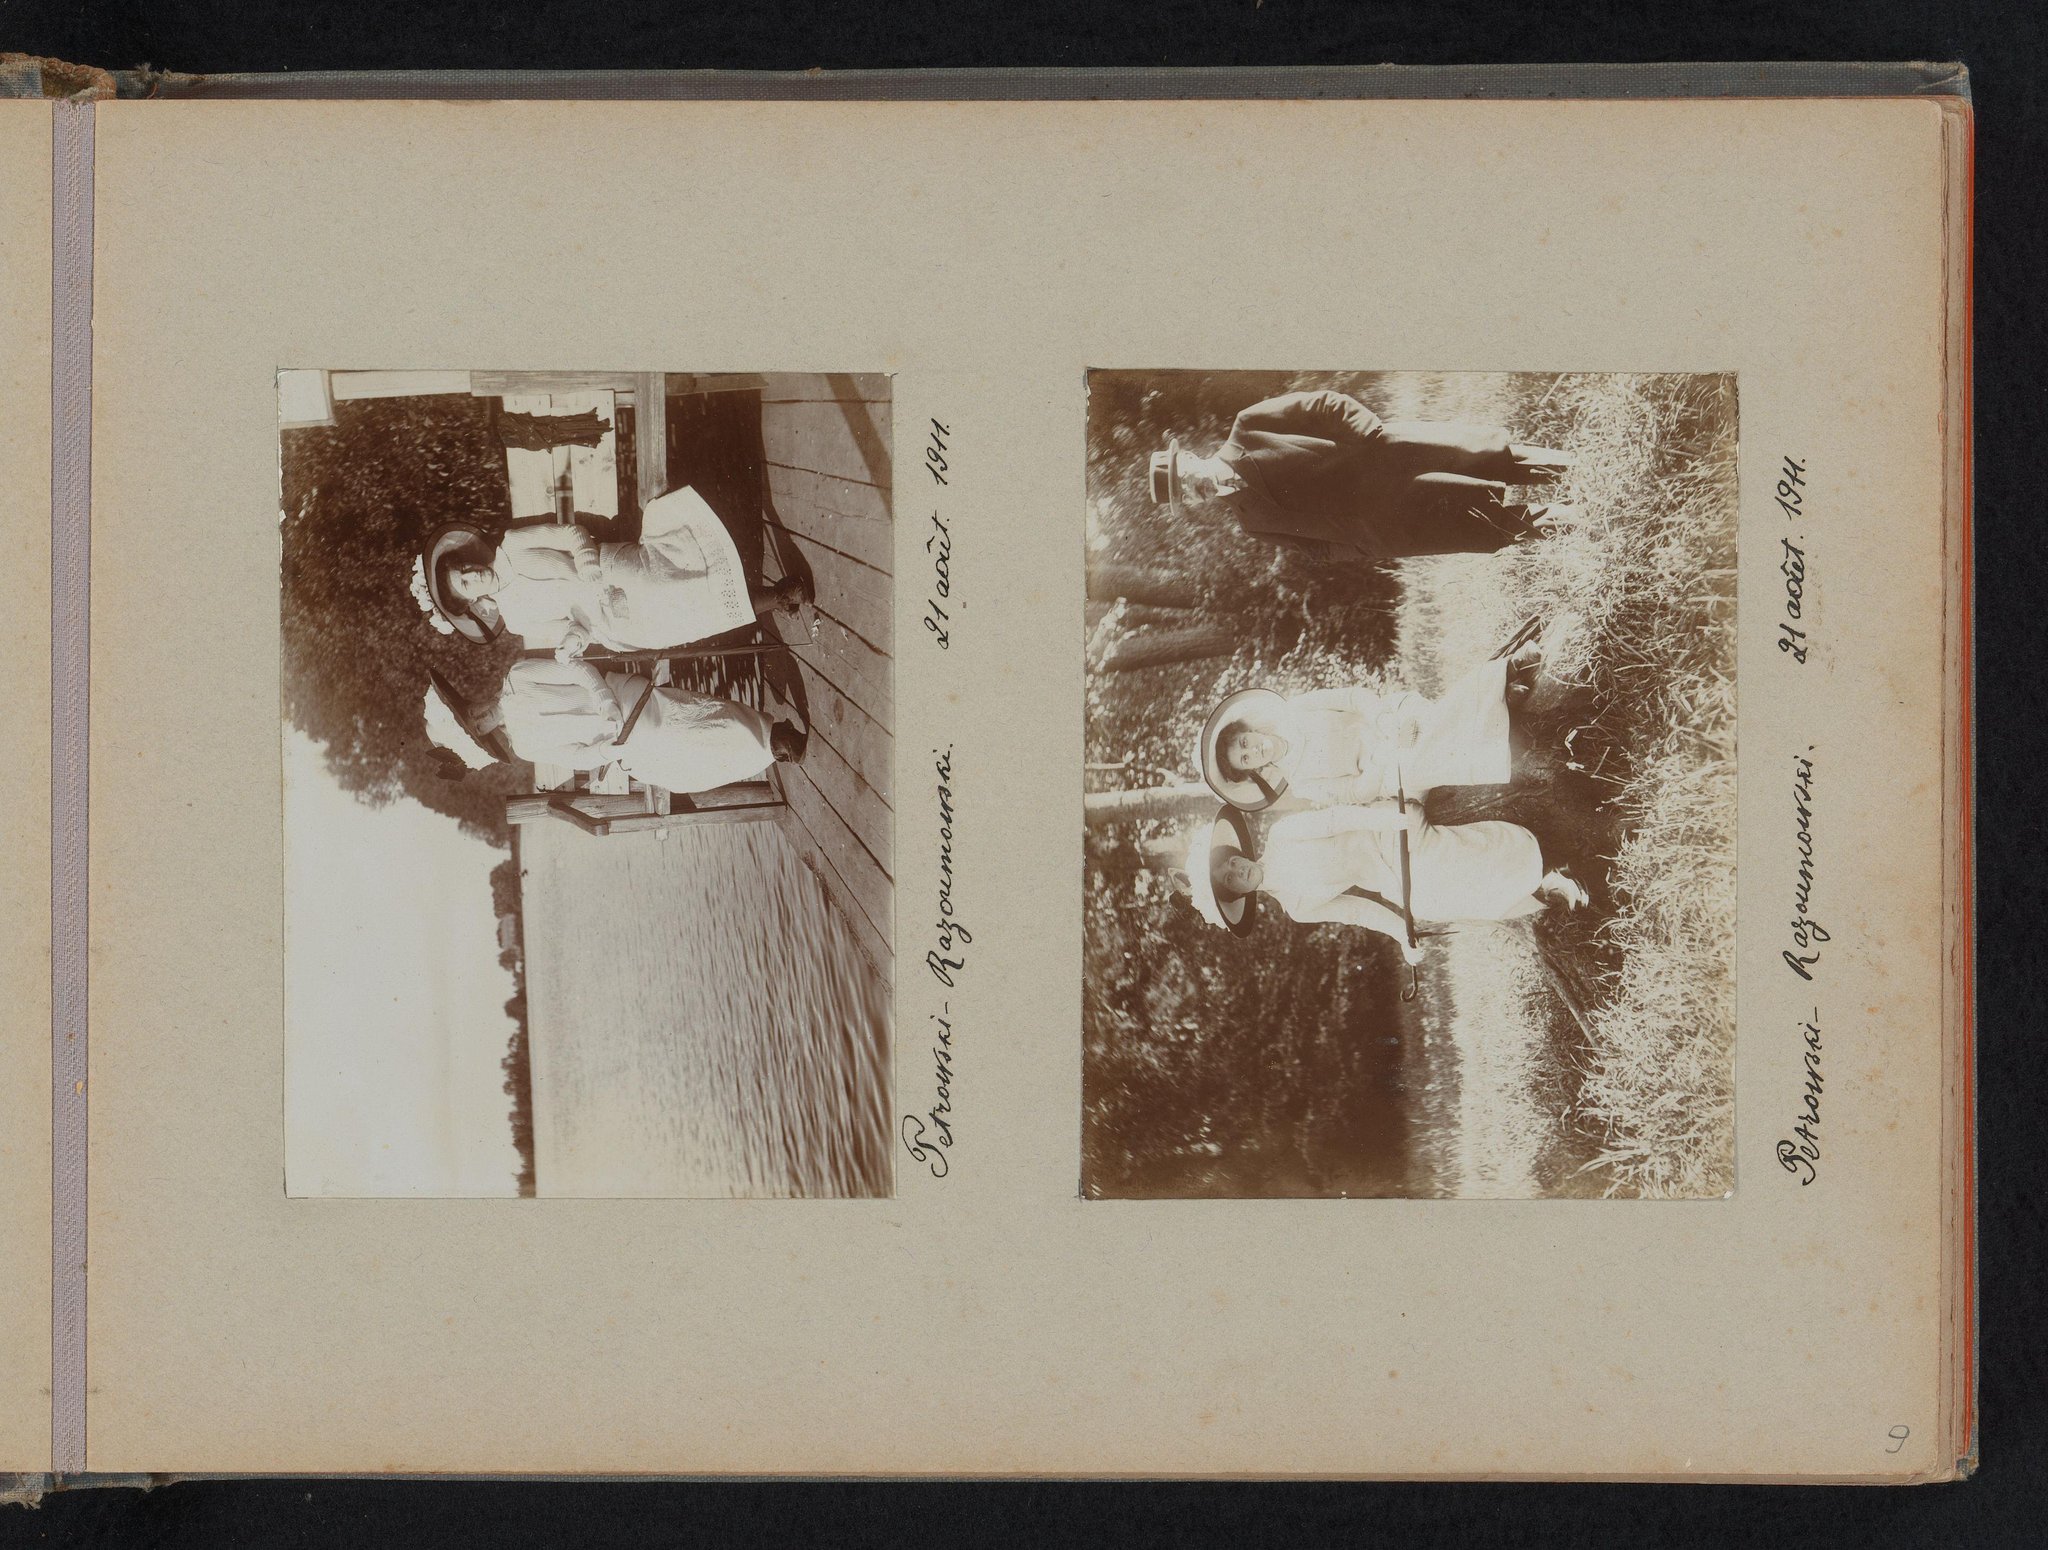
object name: photograph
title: Twee vrouwen op een bank aan een meer en twee vrouwen zittend in het bos naast een man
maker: Anonymous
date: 1911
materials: paper, cardboard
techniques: collodion silver print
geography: russia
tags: historical persons, lake, forest, wood, russia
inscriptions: inscription: ‘Petrowski- Razoumouski. 21 août. 1911.’, inscription: ‘Petrowski- Razoumouski. 21 août. 1911.’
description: Deze foto's maken deel uit van een album.